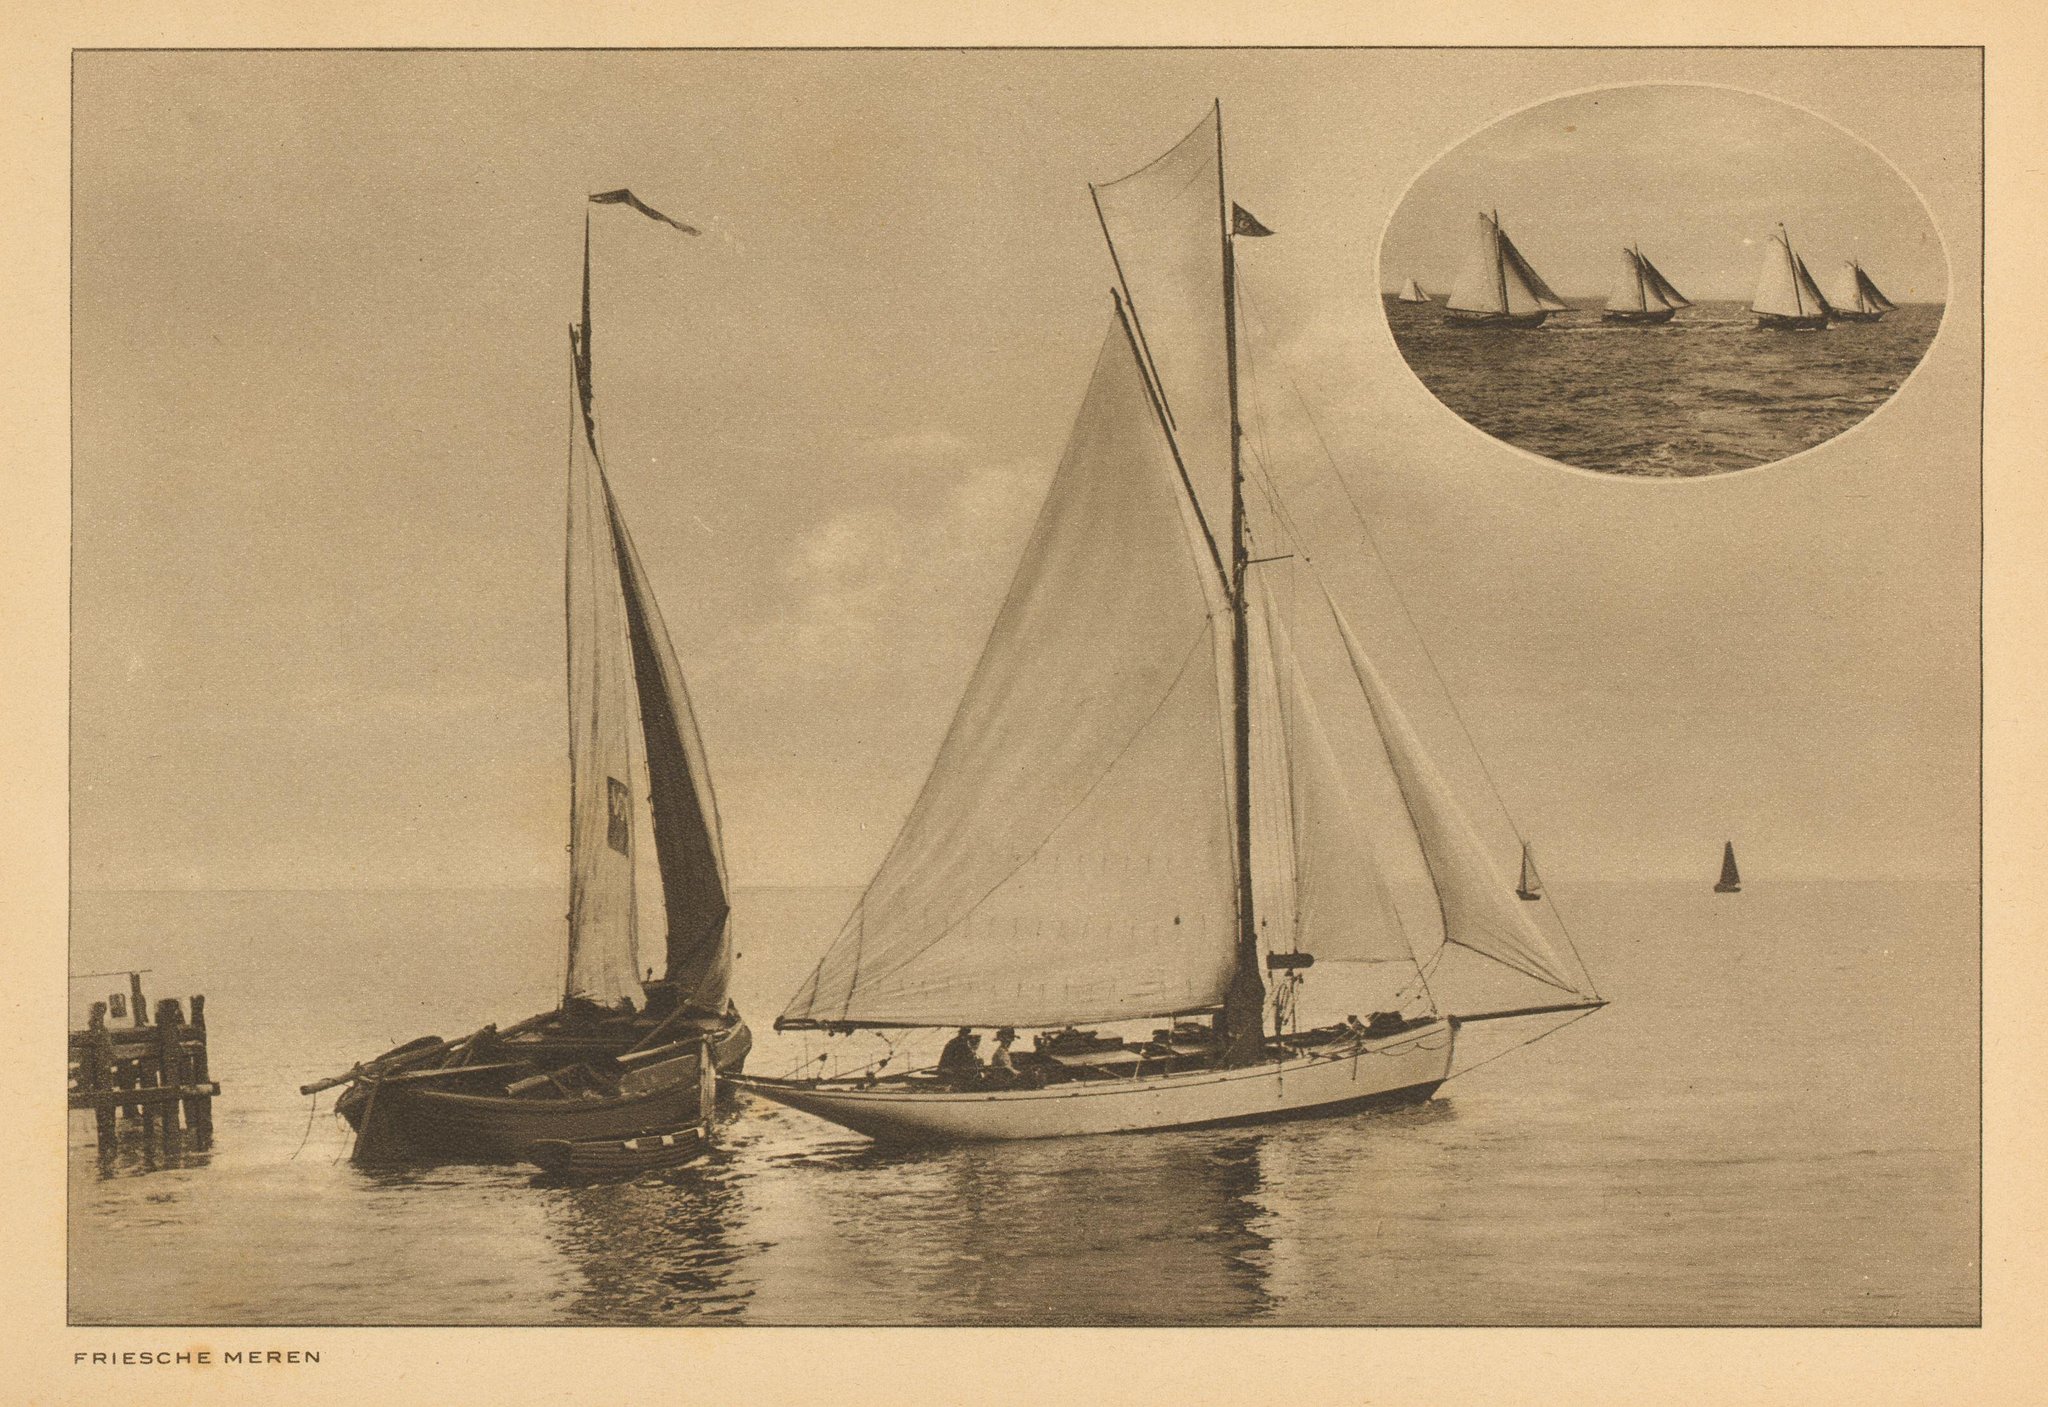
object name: photomechanical print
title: Friesche meren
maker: Anonymous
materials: paper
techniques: rotogravure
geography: leiden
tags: sailing-ship, sailing-boat, lake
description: Deze prent maakt deel uit van een album.